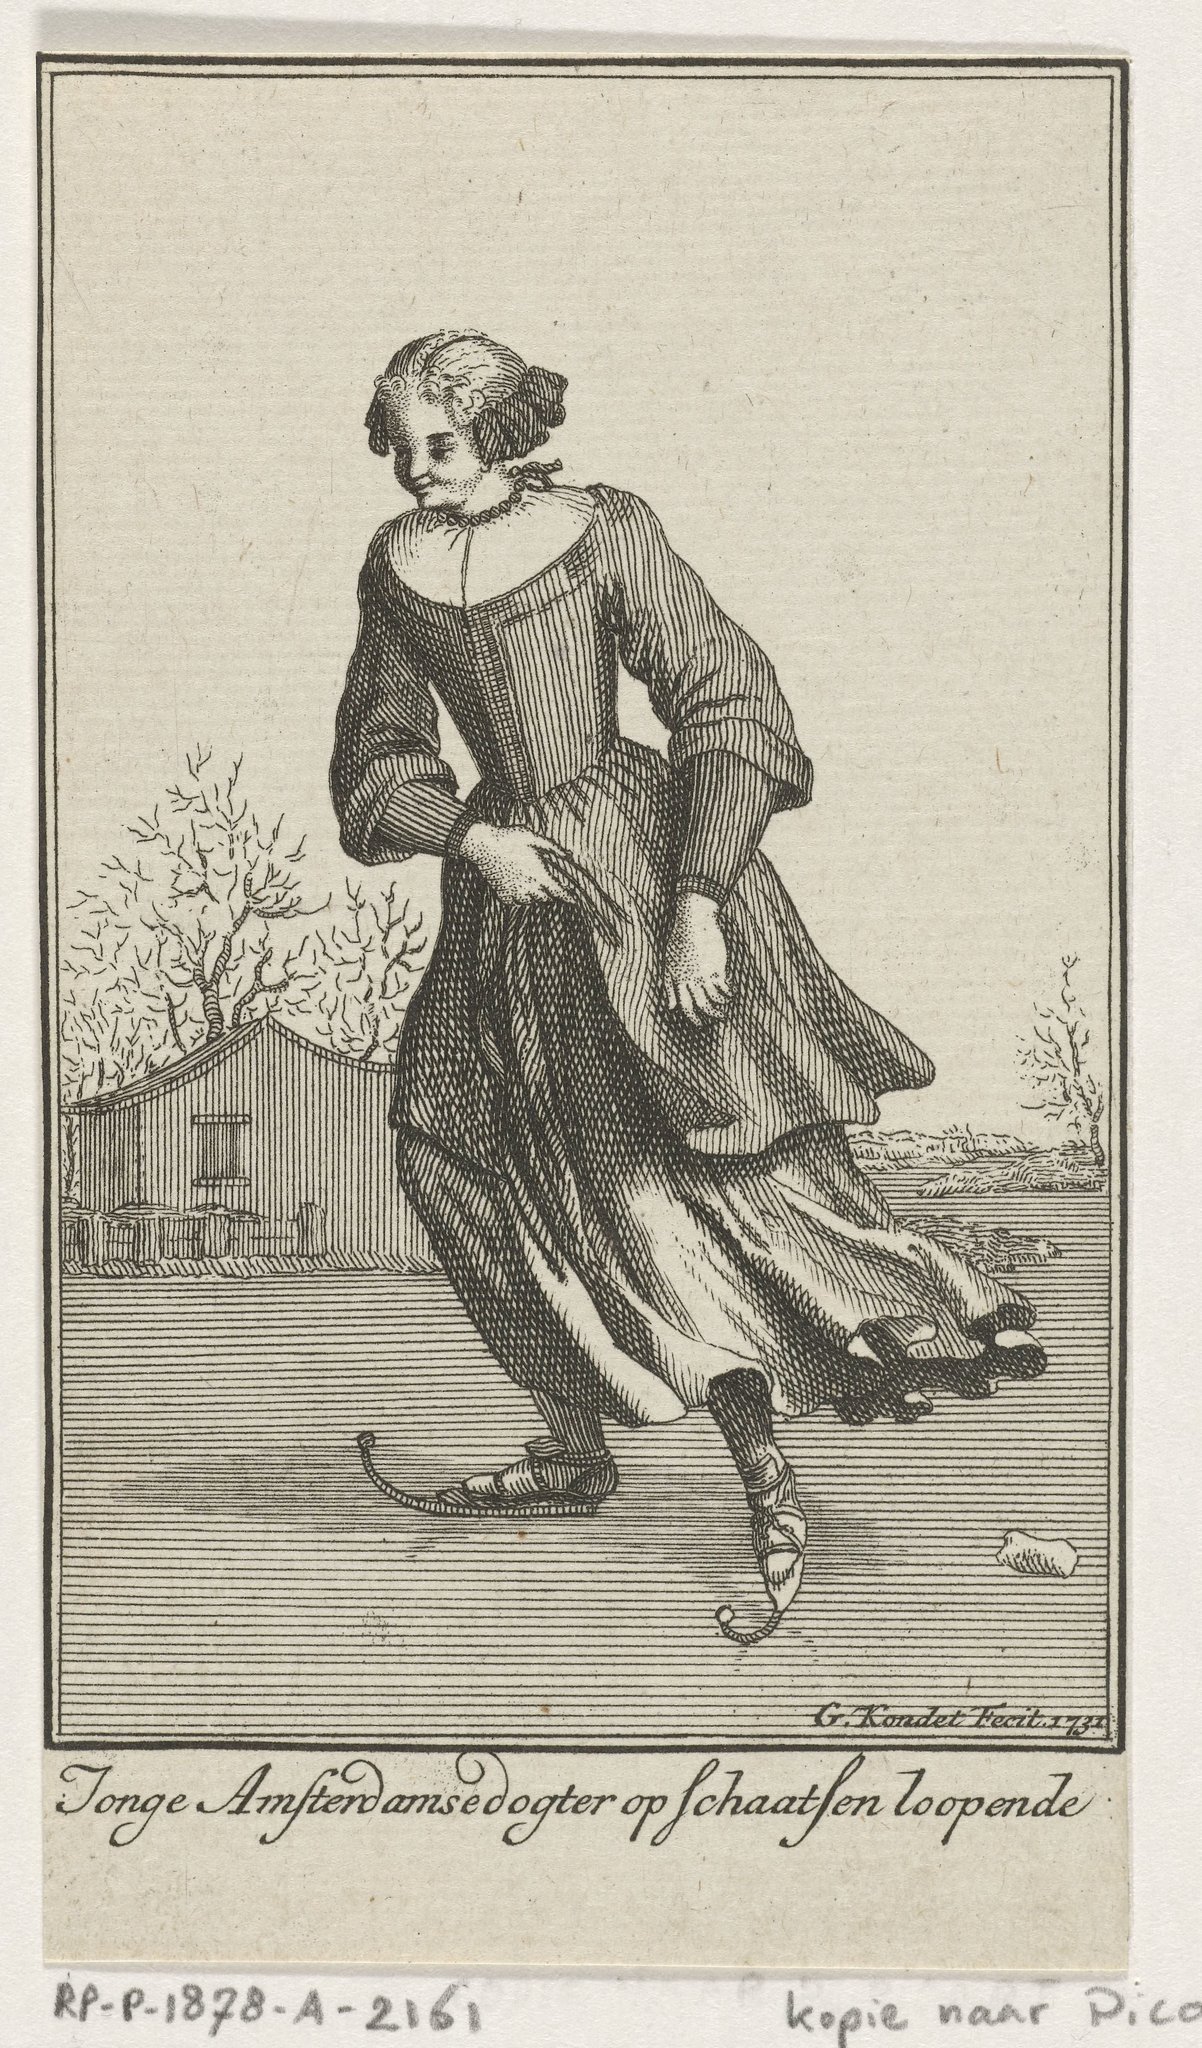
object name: print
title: Schaatsende vrouw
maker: gerardus condet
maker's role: print maker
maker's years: 1715-1764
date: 1731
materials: paper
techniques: engraving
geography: amsterdam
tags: icing, frosting, adult woman, skates (winter sports)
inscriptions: collector's mark: Lugt 2228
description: Een jonge vrouw schaatst over het ijs naar links, haar rokken wapperend in de wind. Achter haar een huis en enkele bomen.